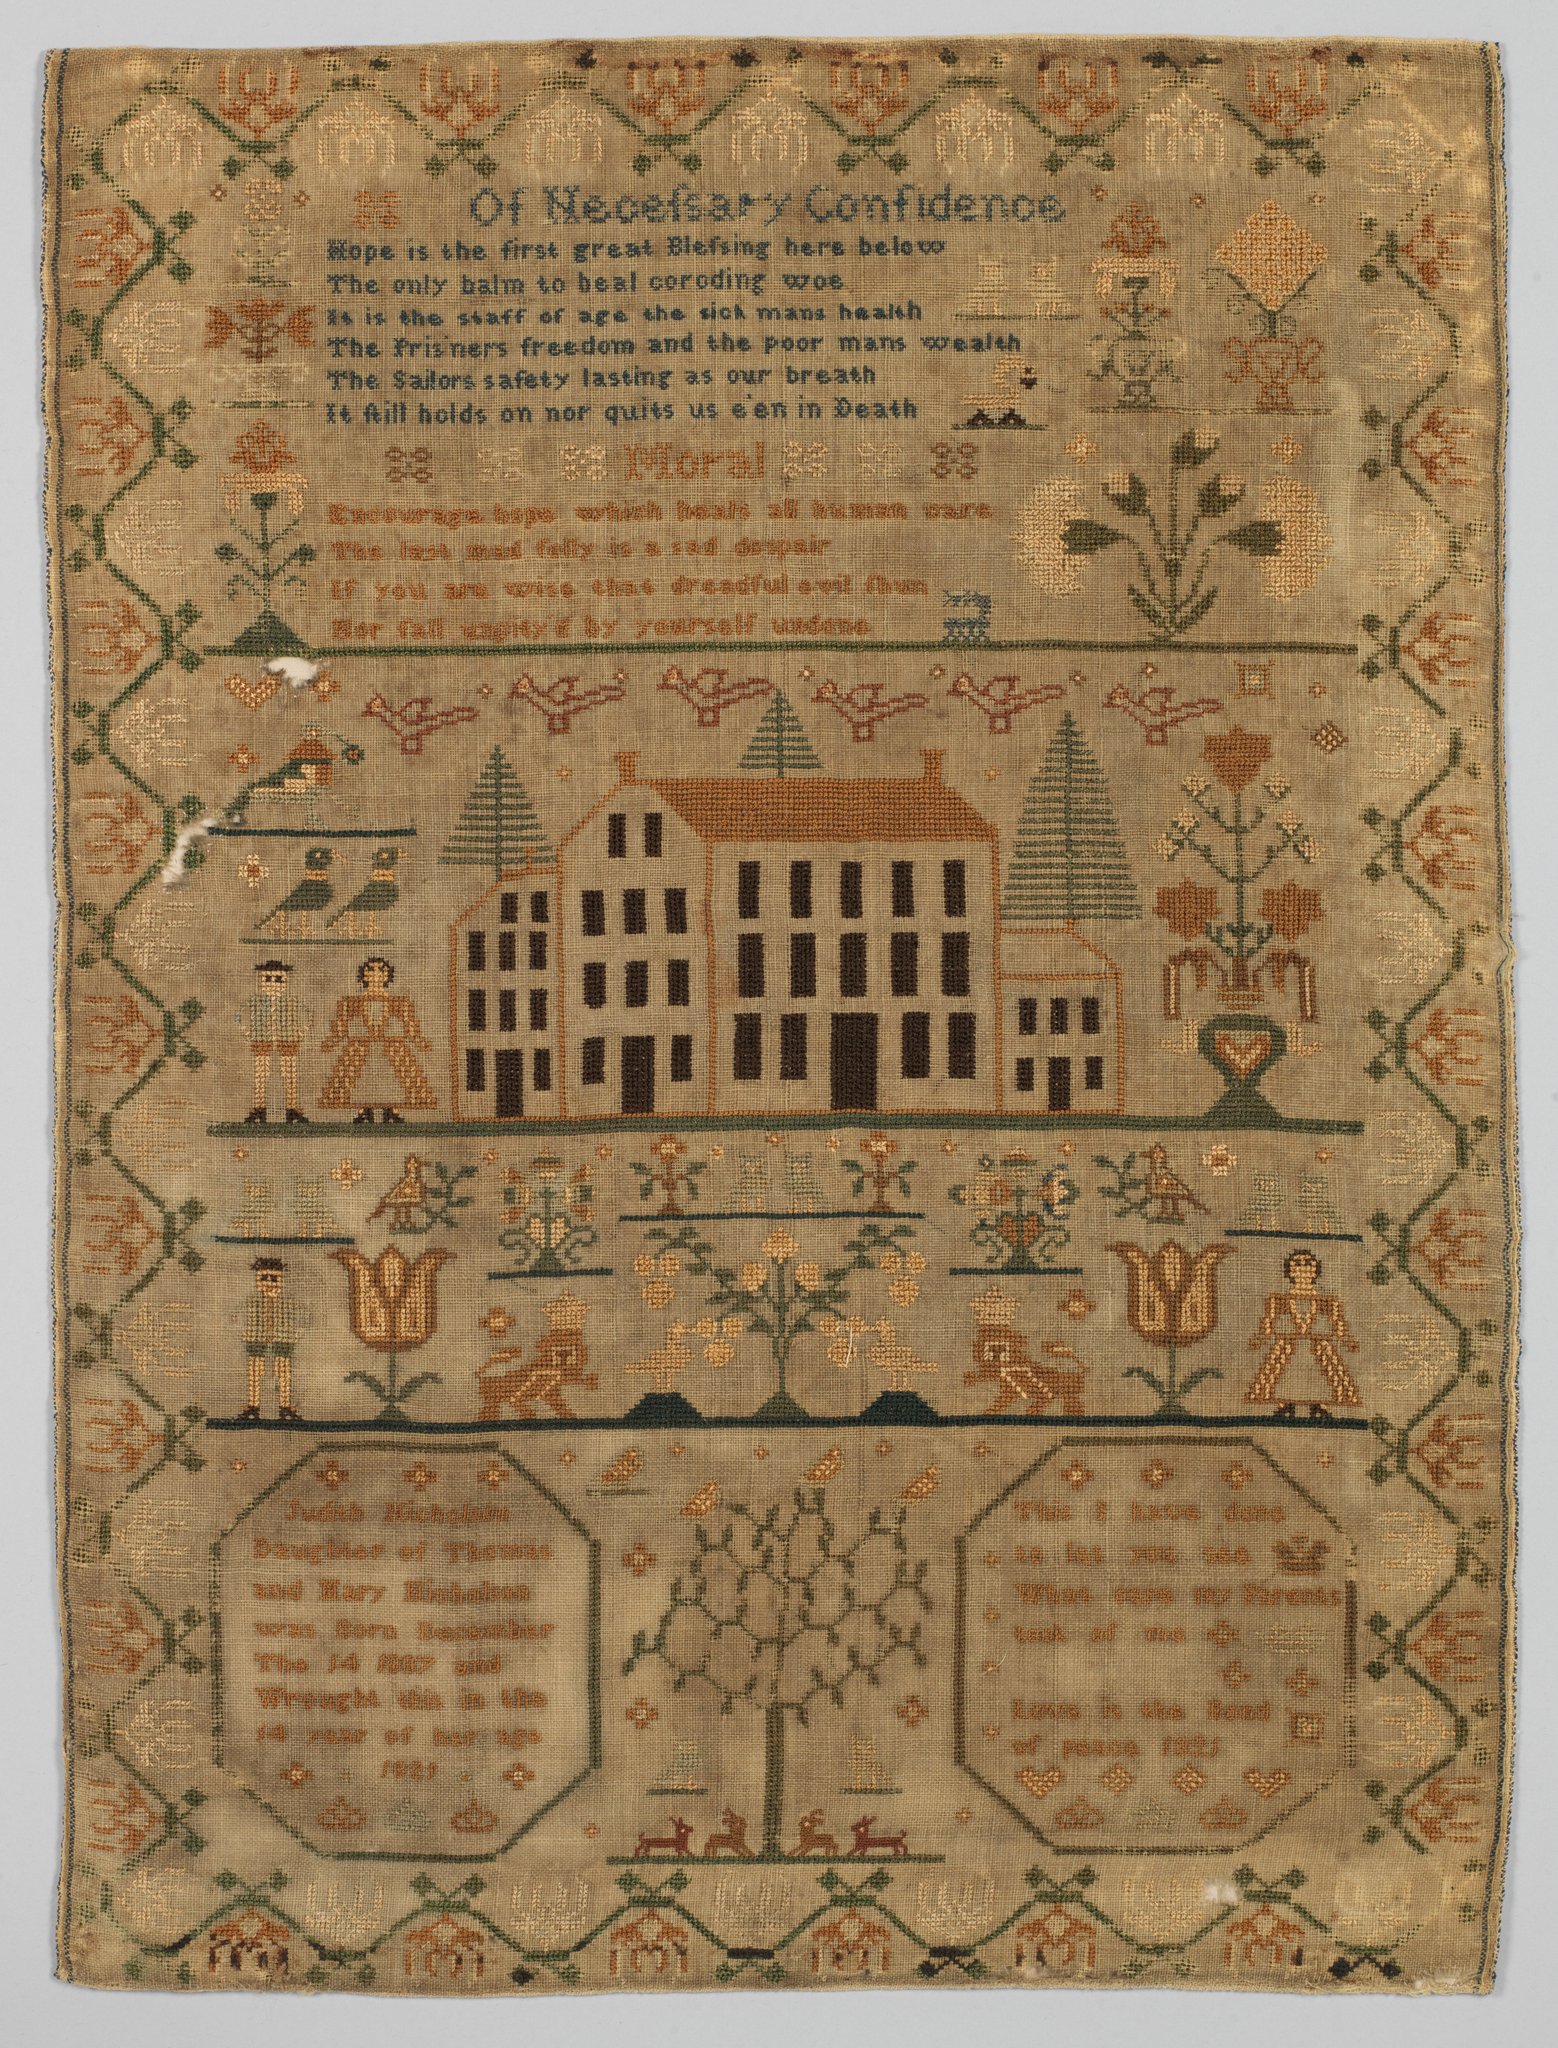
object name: sampler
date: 1821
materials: canvas, silk, wool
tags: birds,houses,men,women